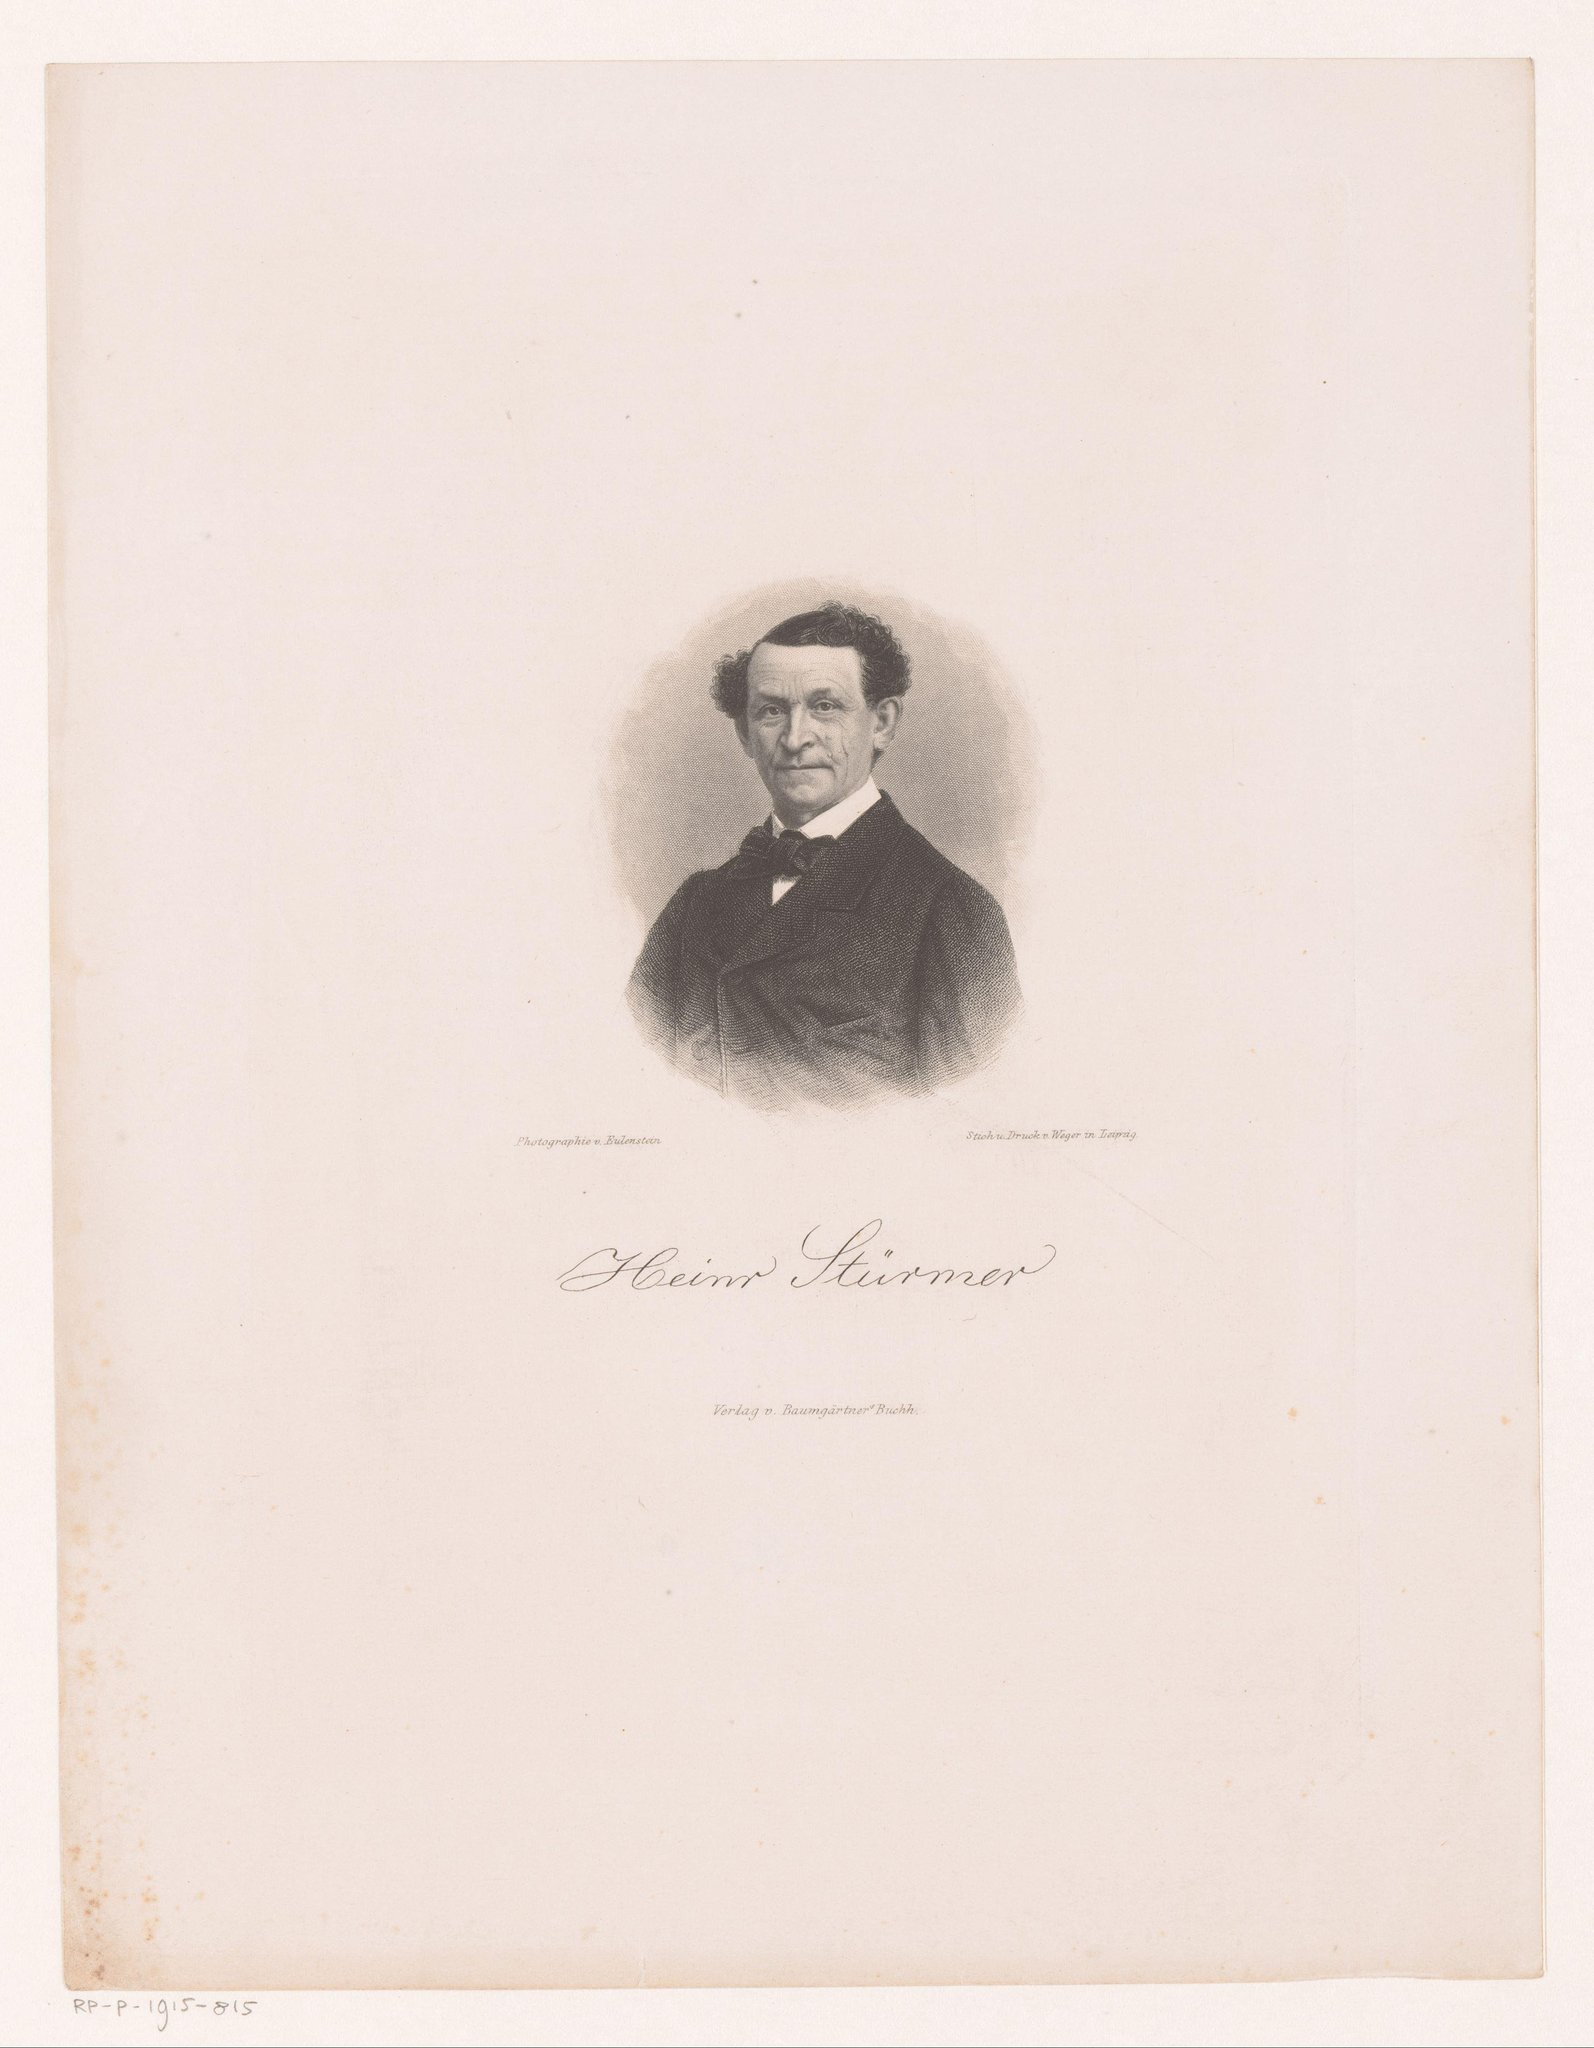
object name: print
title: Portret van Heinrich Stürmer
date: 1849-1892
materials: paper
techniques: engraving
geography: leipzig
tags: historical persons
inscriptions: collector's mark: Lugt 2228